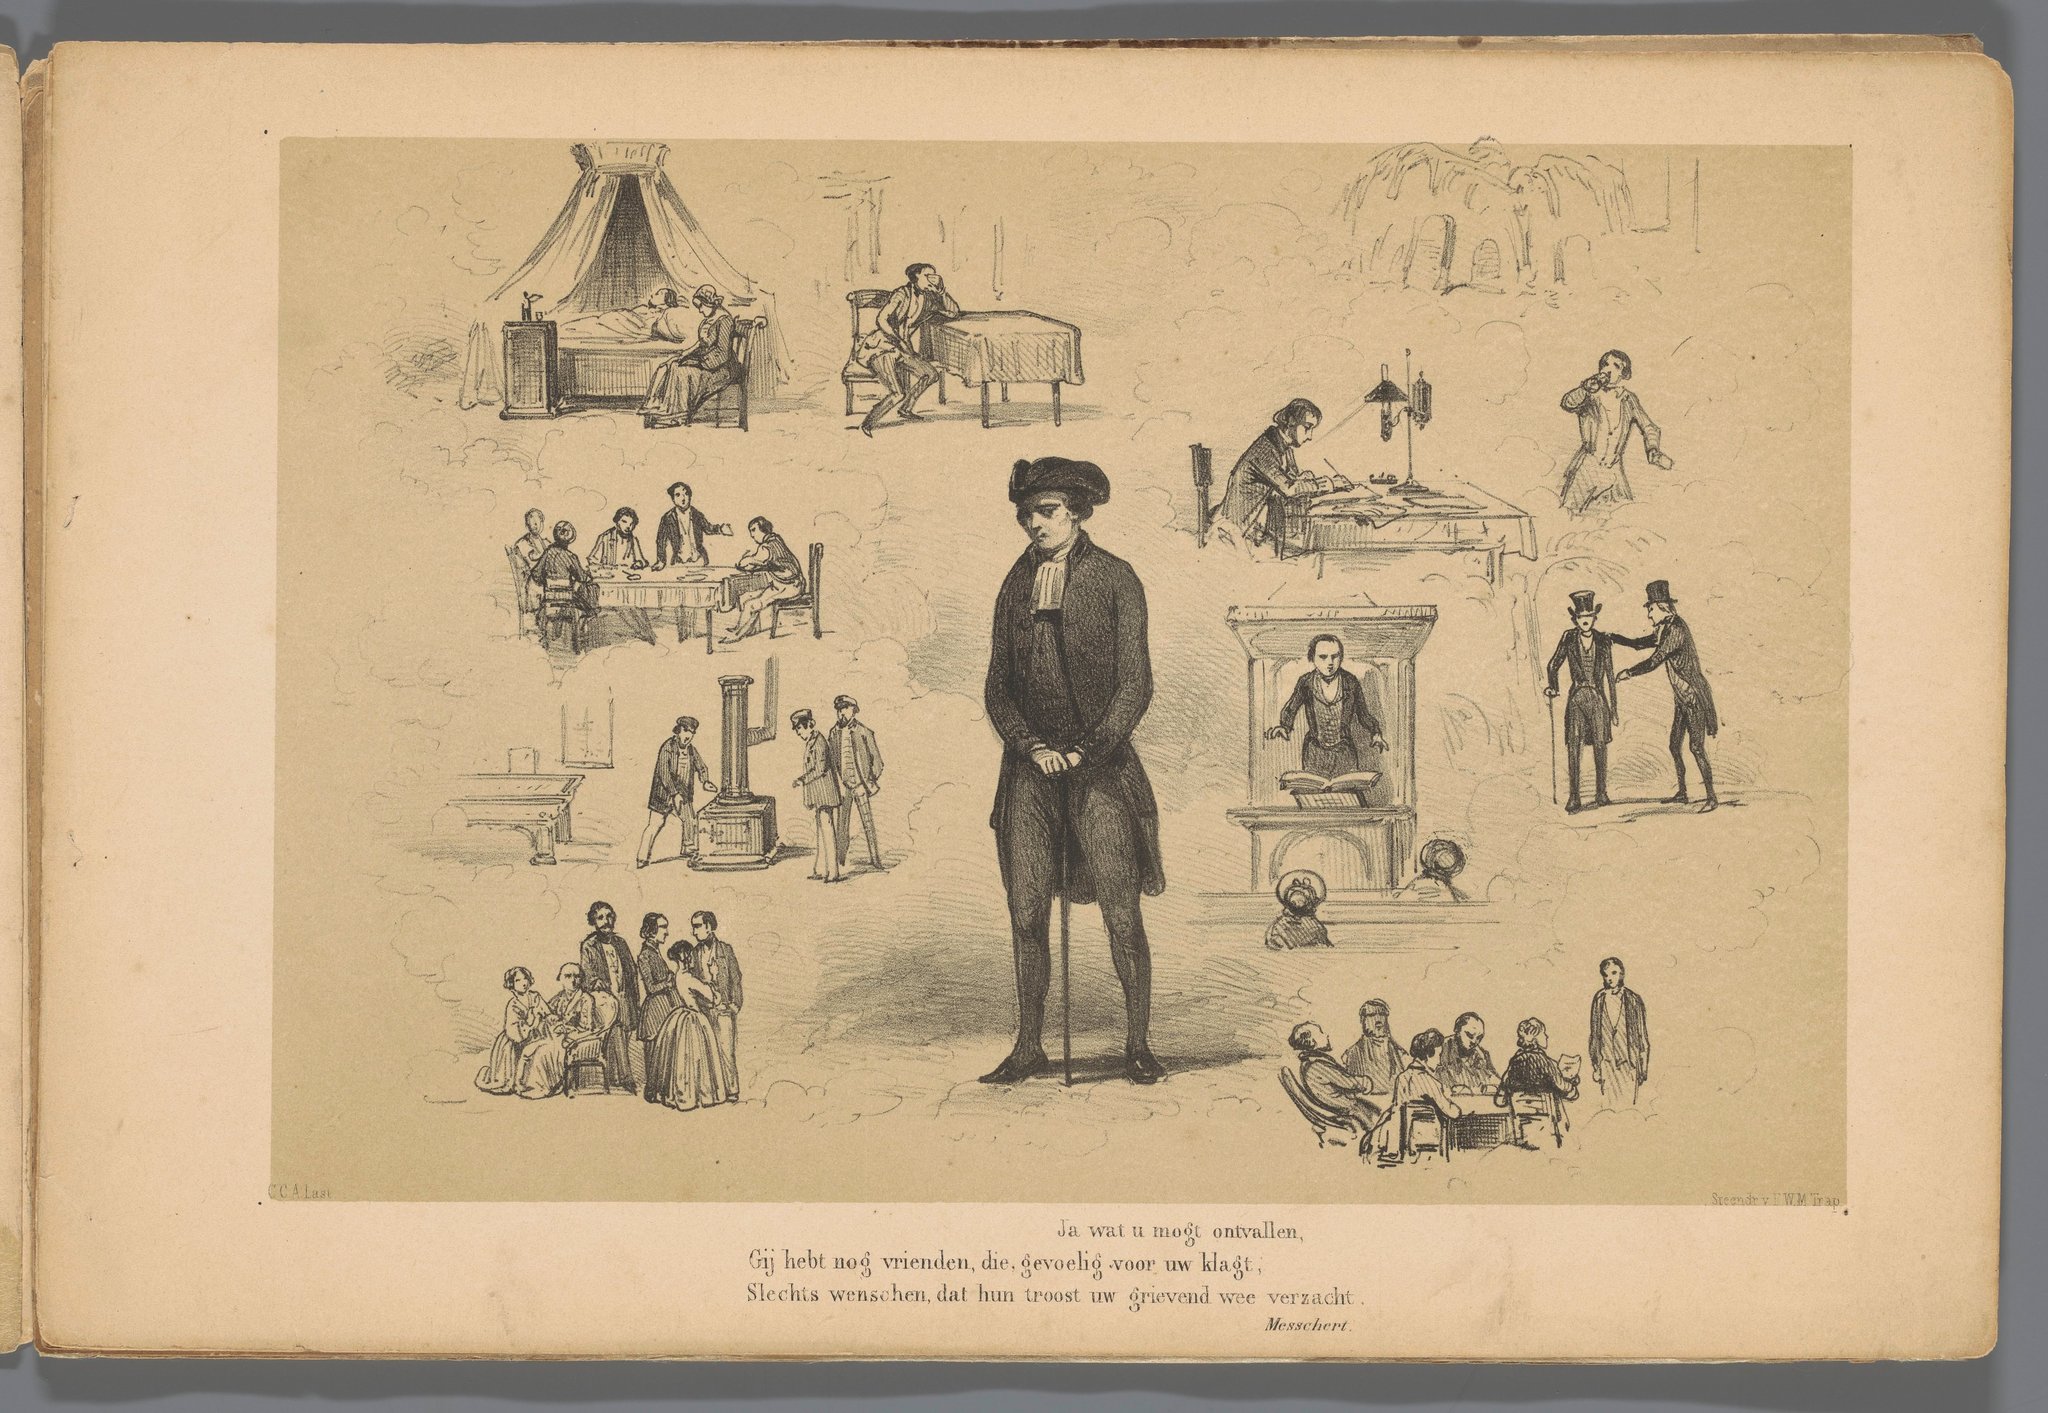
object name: print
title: Tien jaren later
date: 1836-1876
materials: paper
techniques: tone lithography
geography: leiden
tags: walking-stick, staff, head-gear: hat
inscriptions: collector's mark: Lugt 2228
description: De serie met omslag werd samengesteld door Jan van der Hoeven (Leiden 1834 - Rotterdam 1900). Van der Hoeven was mede oprichter van het Sophia-Kinderziekenhuis in Rotterdam en was als heelmeester verbonden aan het stedelijk ziekenhuis aldaar.